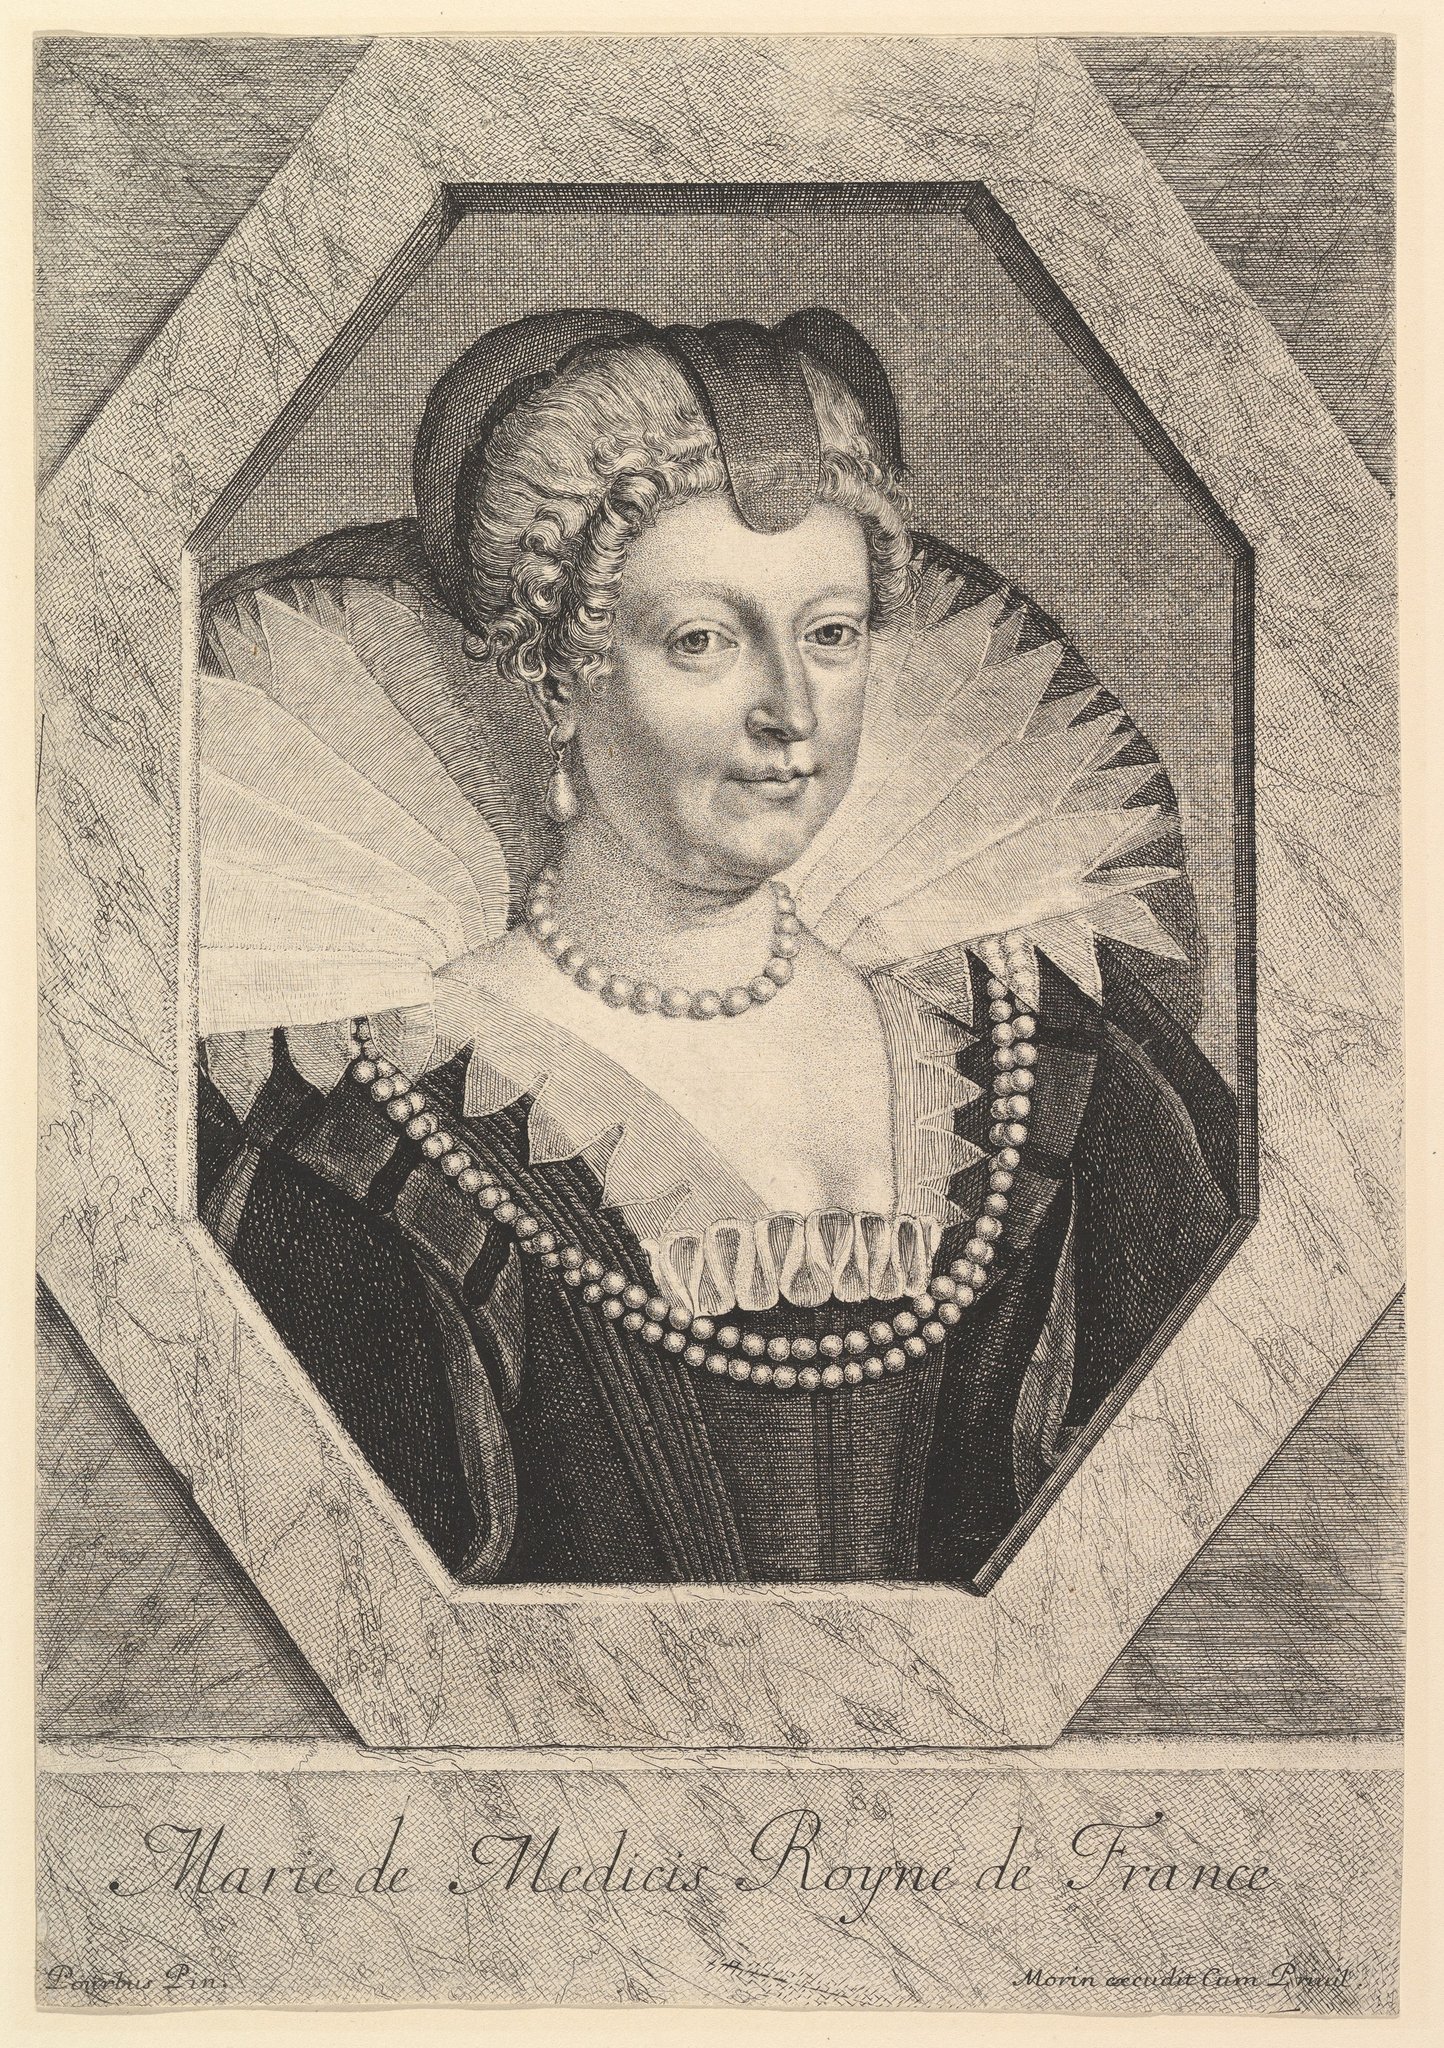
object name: print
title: Marie de Medicis, reine de France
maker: jean morin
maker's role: artist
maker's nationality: french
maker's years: 1605-1650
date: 1605-1650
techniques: etching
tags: portraits,women